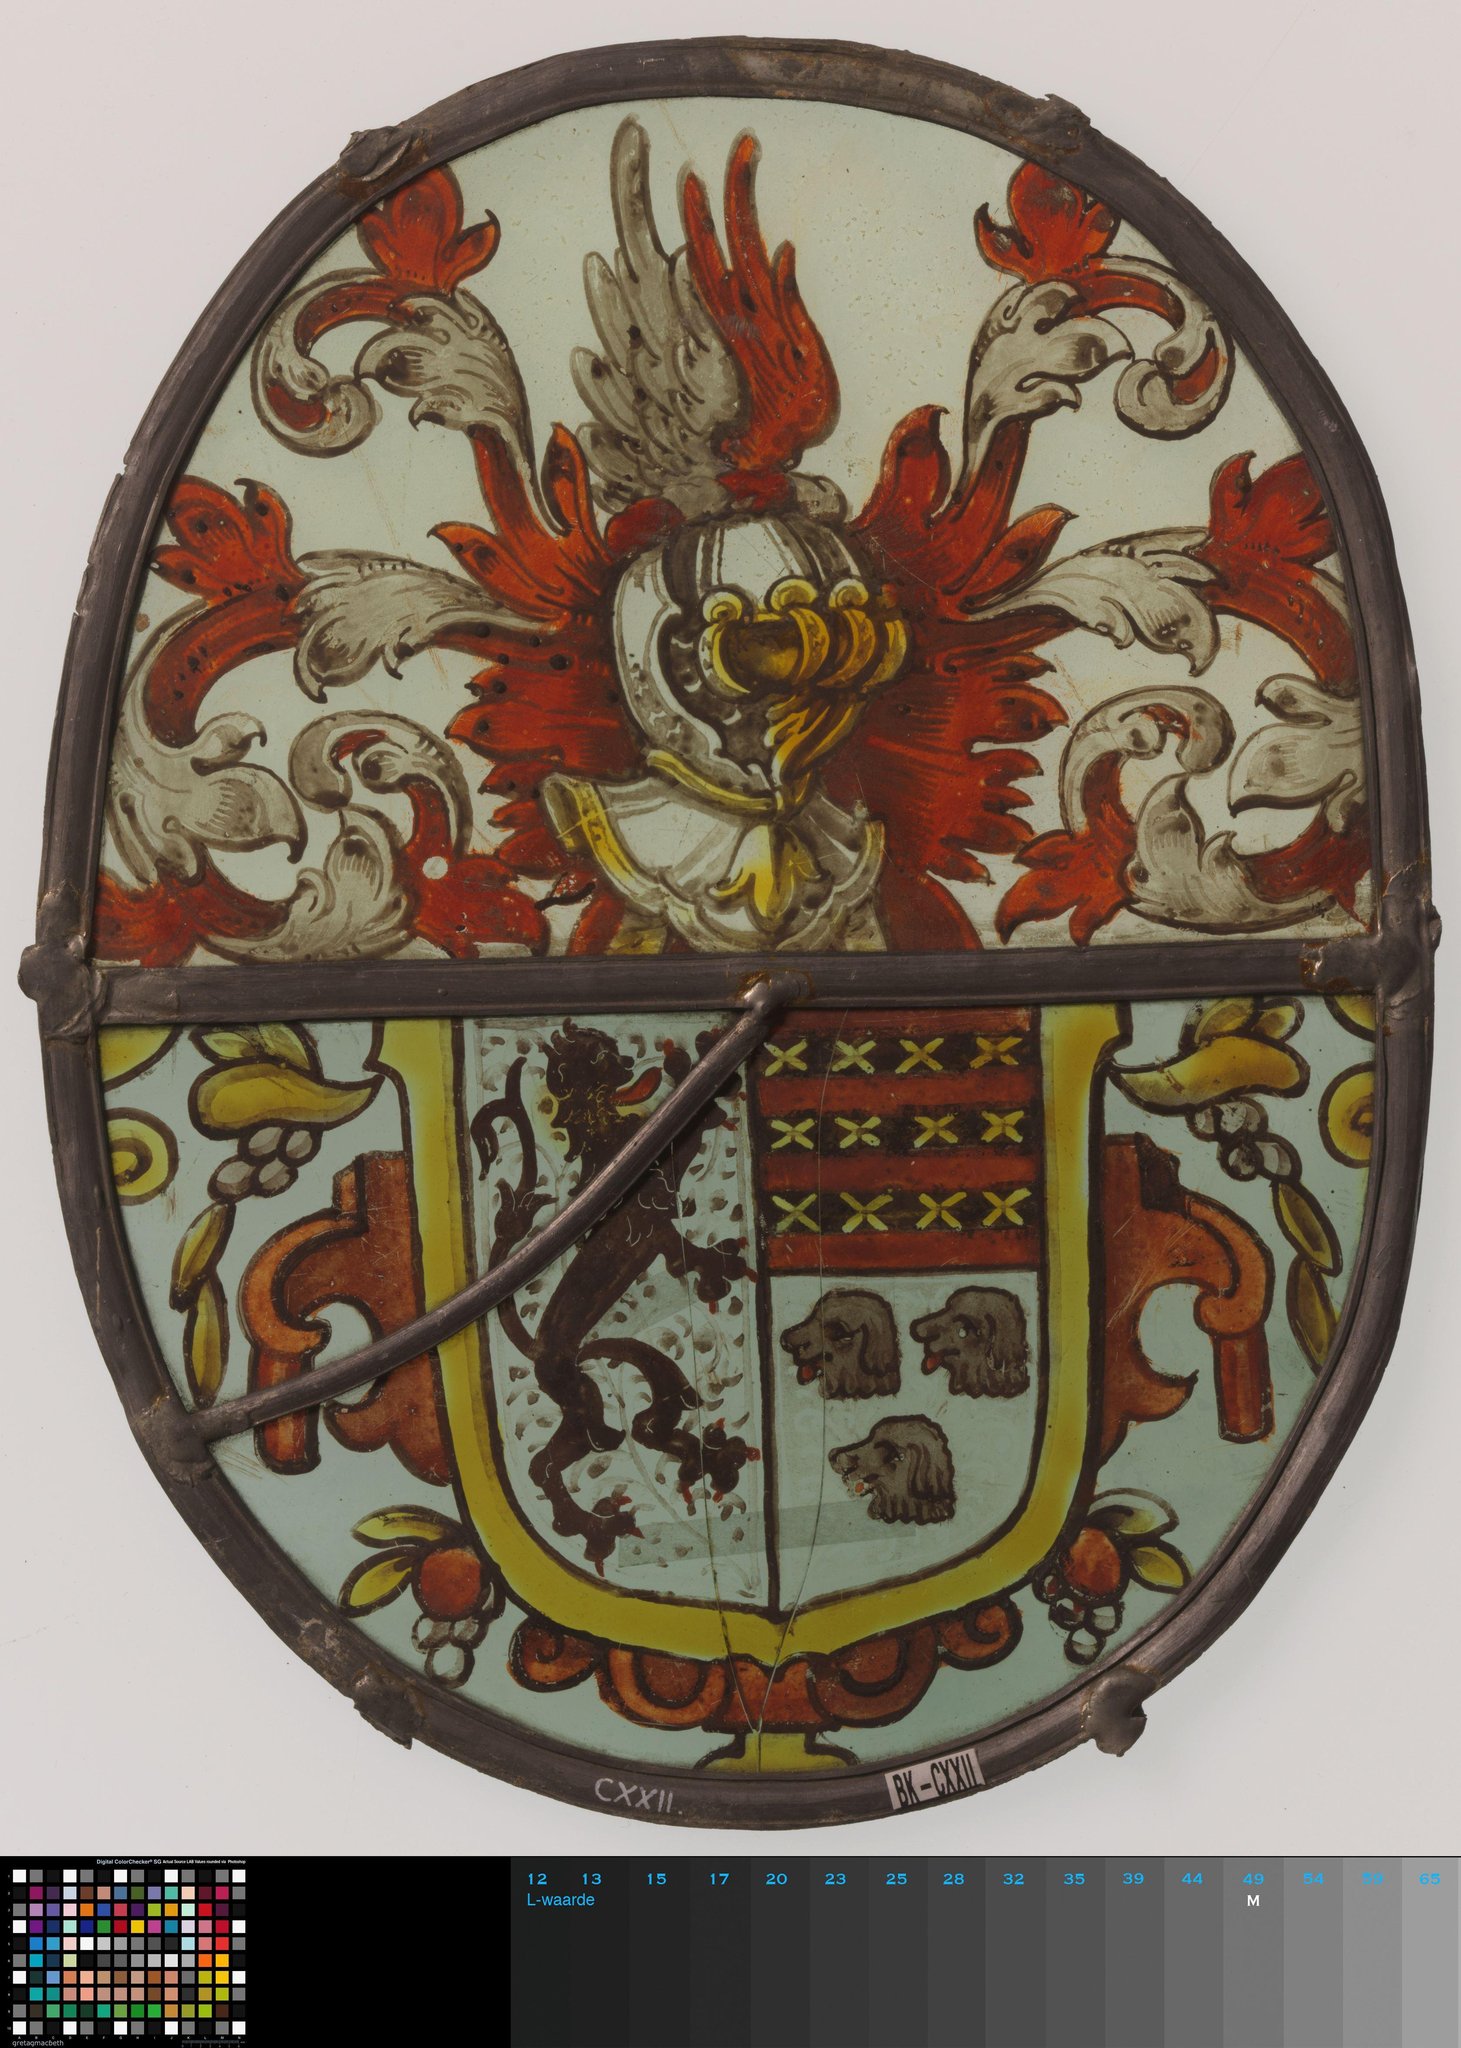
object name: wapenruit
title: Ruit met wapenschild met onder meer drie hondekoppen en een klimmende leeuw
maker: Anonymous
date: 1700-1800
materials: glass, lead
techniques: leading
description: Ruit met wapenschild met onder meer drie hondekoppen en een klimmende leeuw